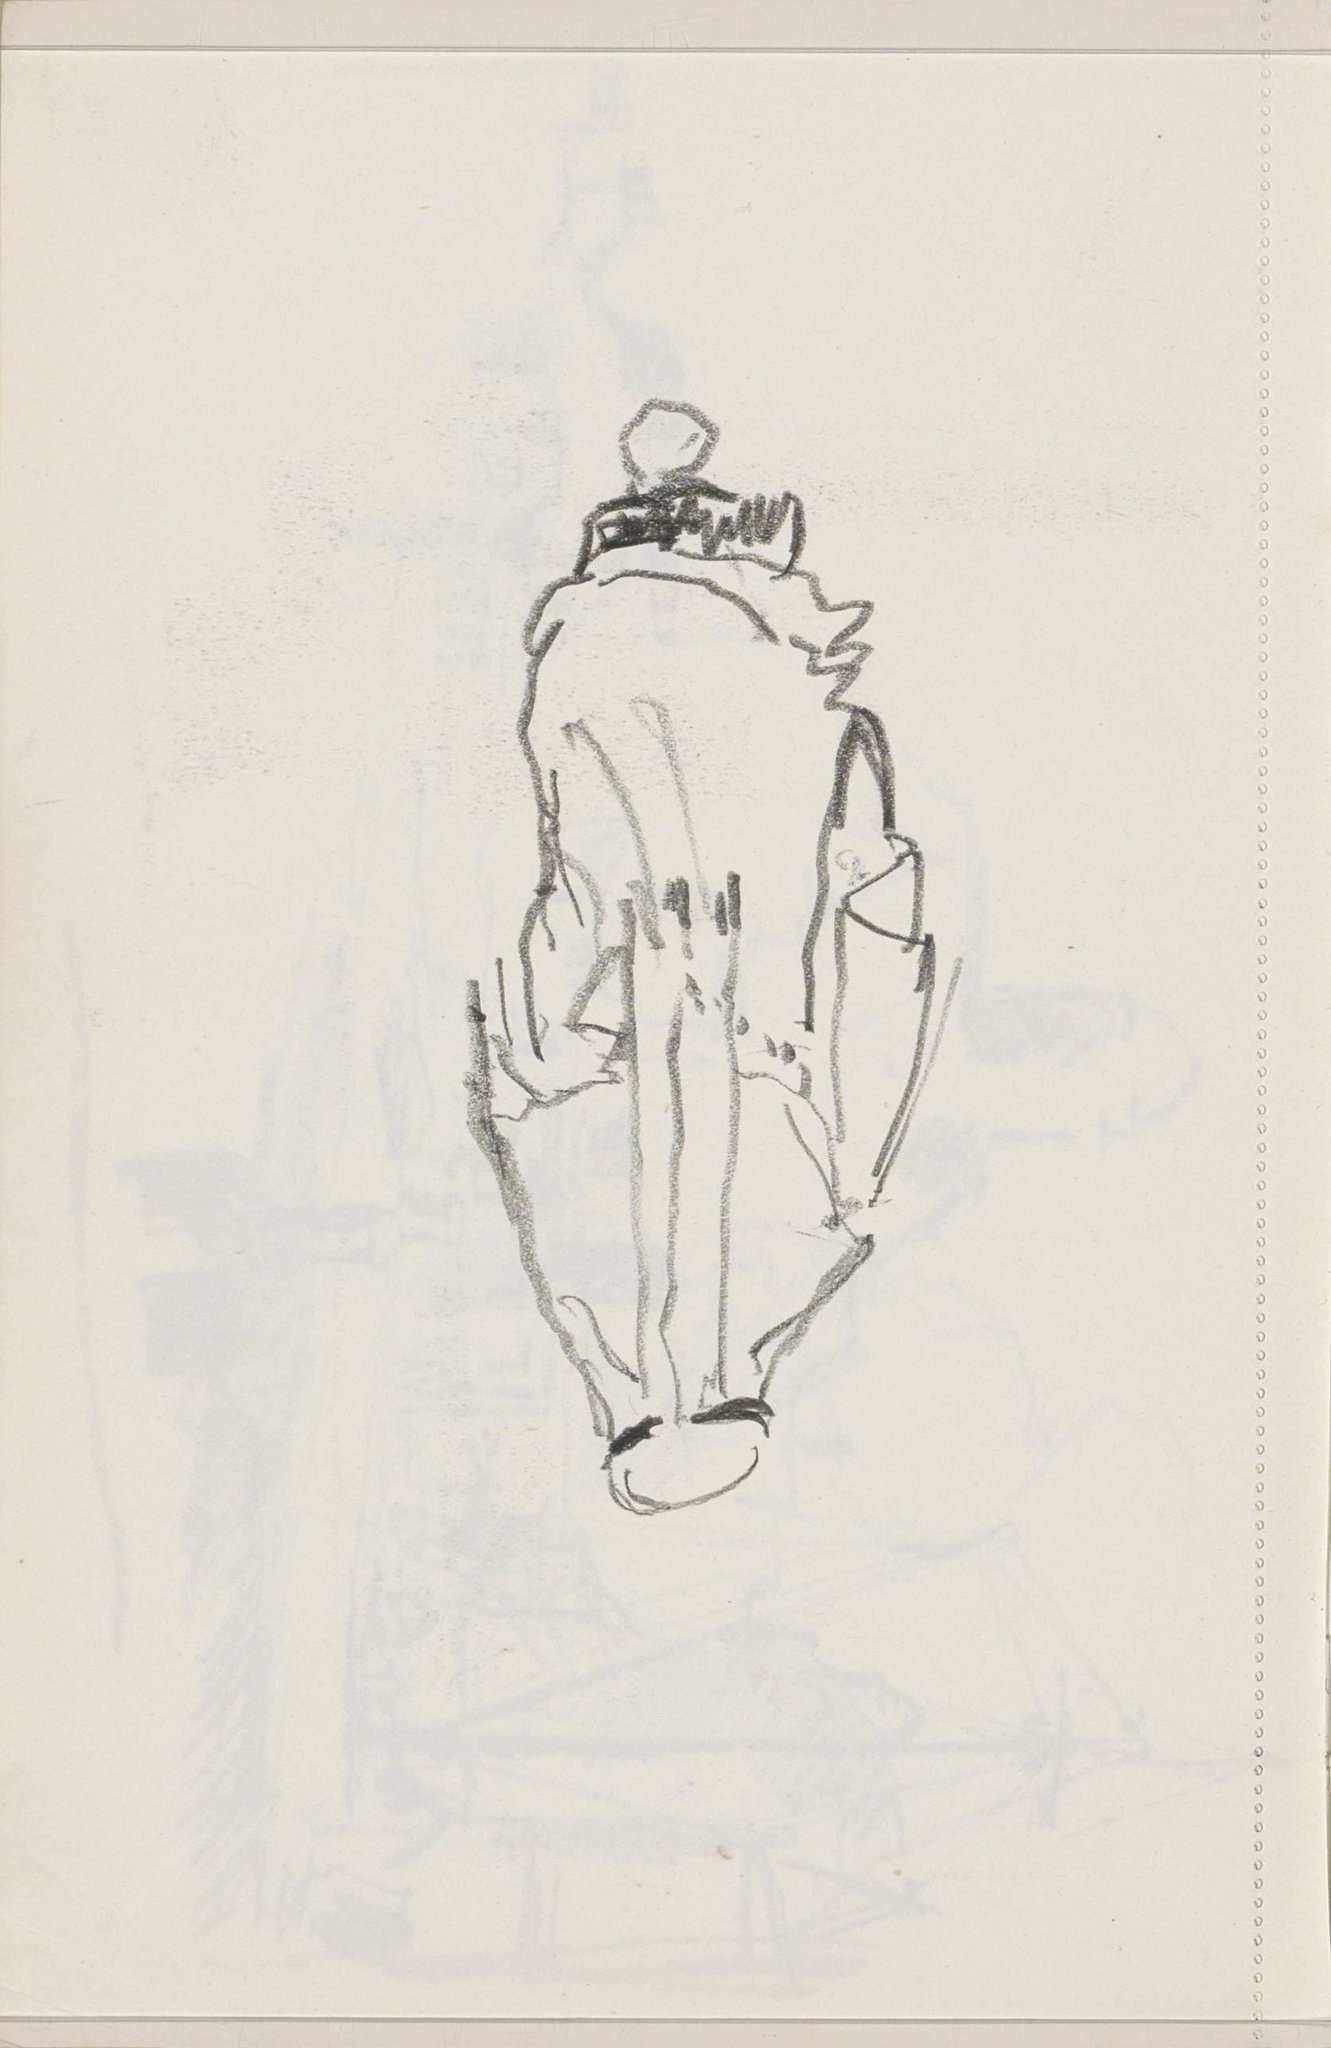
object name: sketchbook leaf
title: Man in oosters kostuum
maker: cornelis vreedenburgh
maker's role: draughtsman, print maker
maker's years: 1880-1946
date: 1935-1936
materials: chalk, paper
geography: maghreb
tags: folk costume, regional costume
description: De man draagt een lang gewaad en heeft het hoofd bedekt met een sluier. Blad 14 verso uit een schetsboek met 73 bladen.